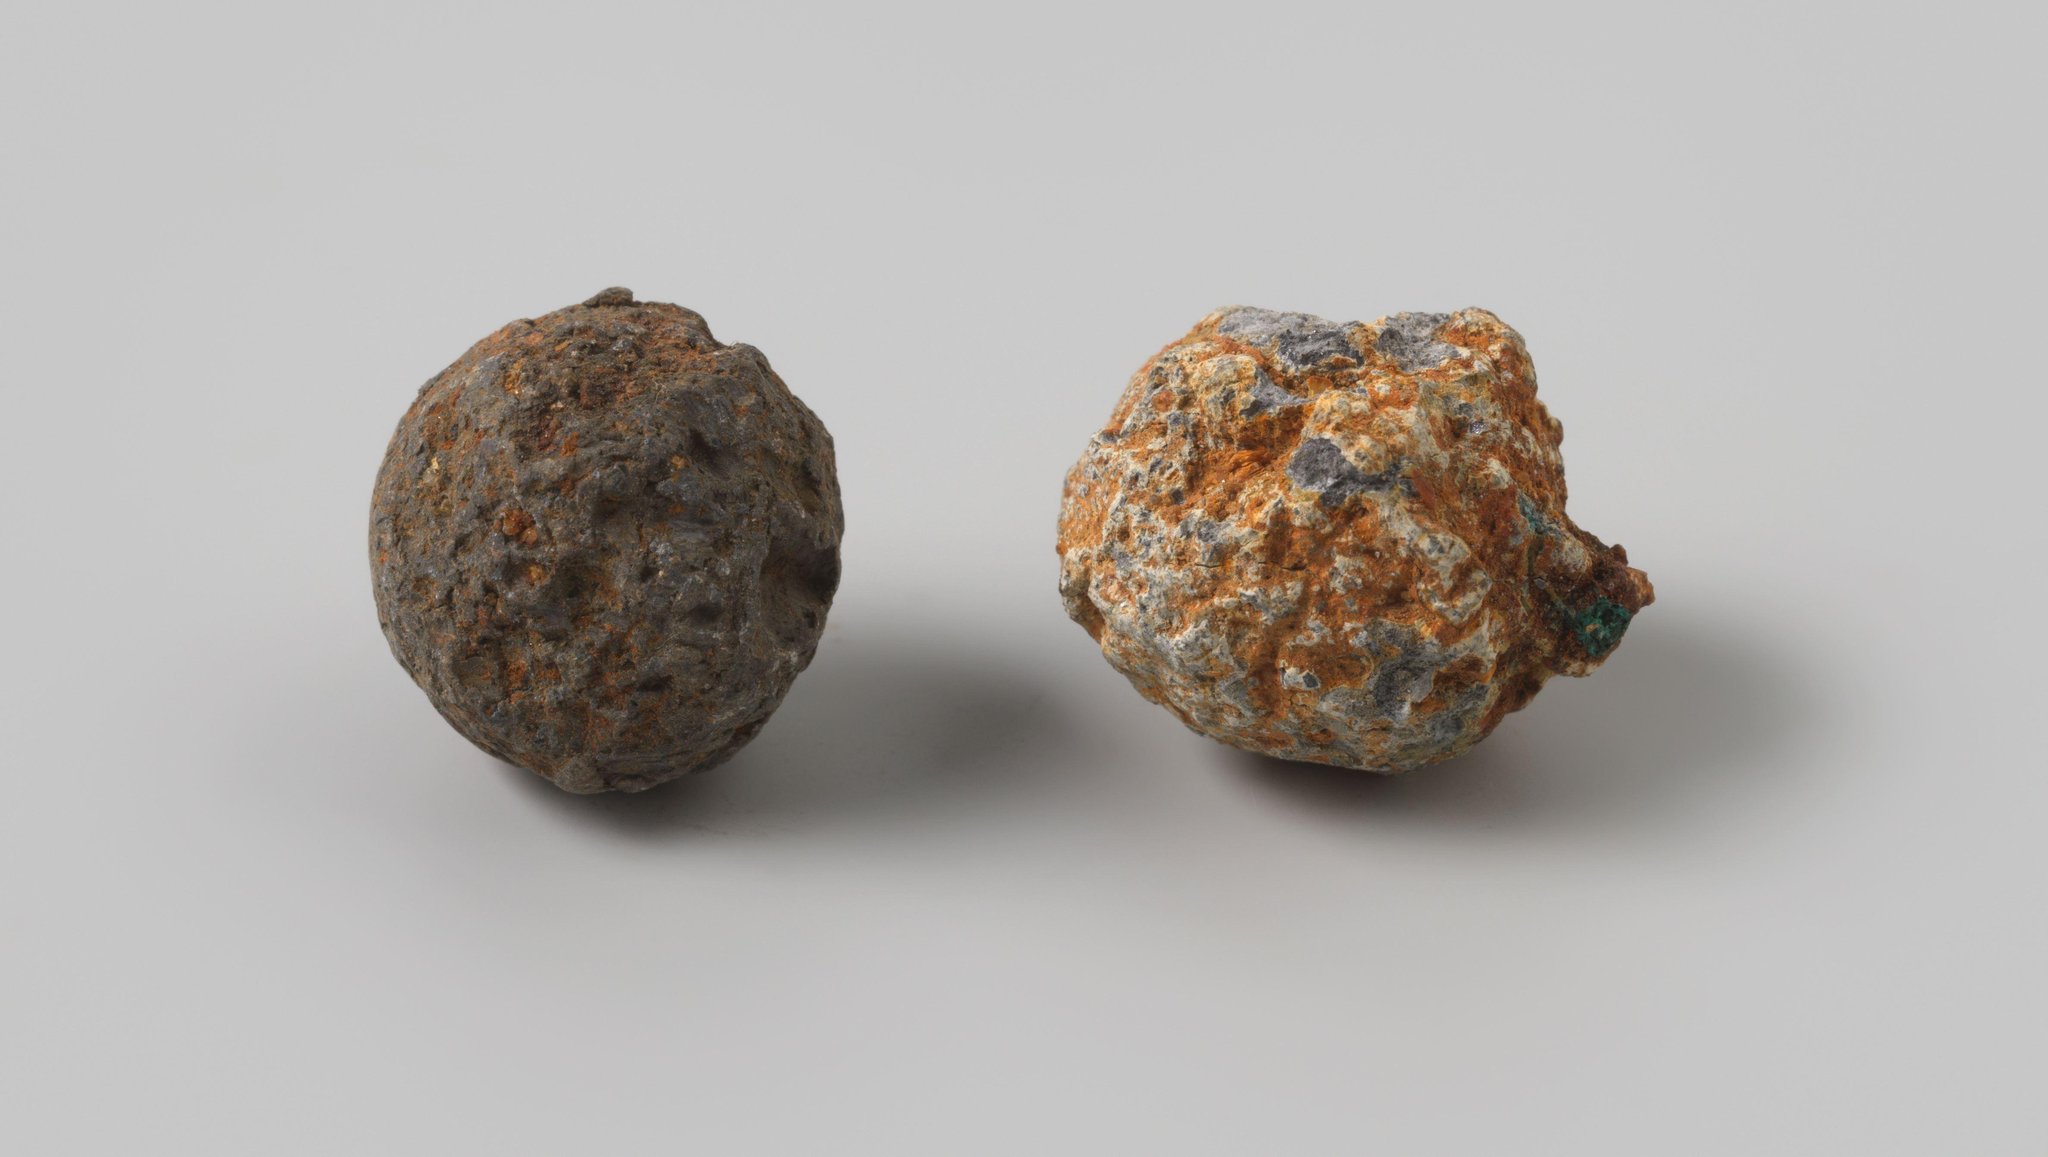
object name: musketkogel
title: Musketkogels uit het wrak van de Oost-Indiëvaarder Hollandia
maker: Anonymous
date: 1700-1743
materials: lead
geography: netherlands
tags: verenigde oostindische compagnie, hollandia (schip), annet